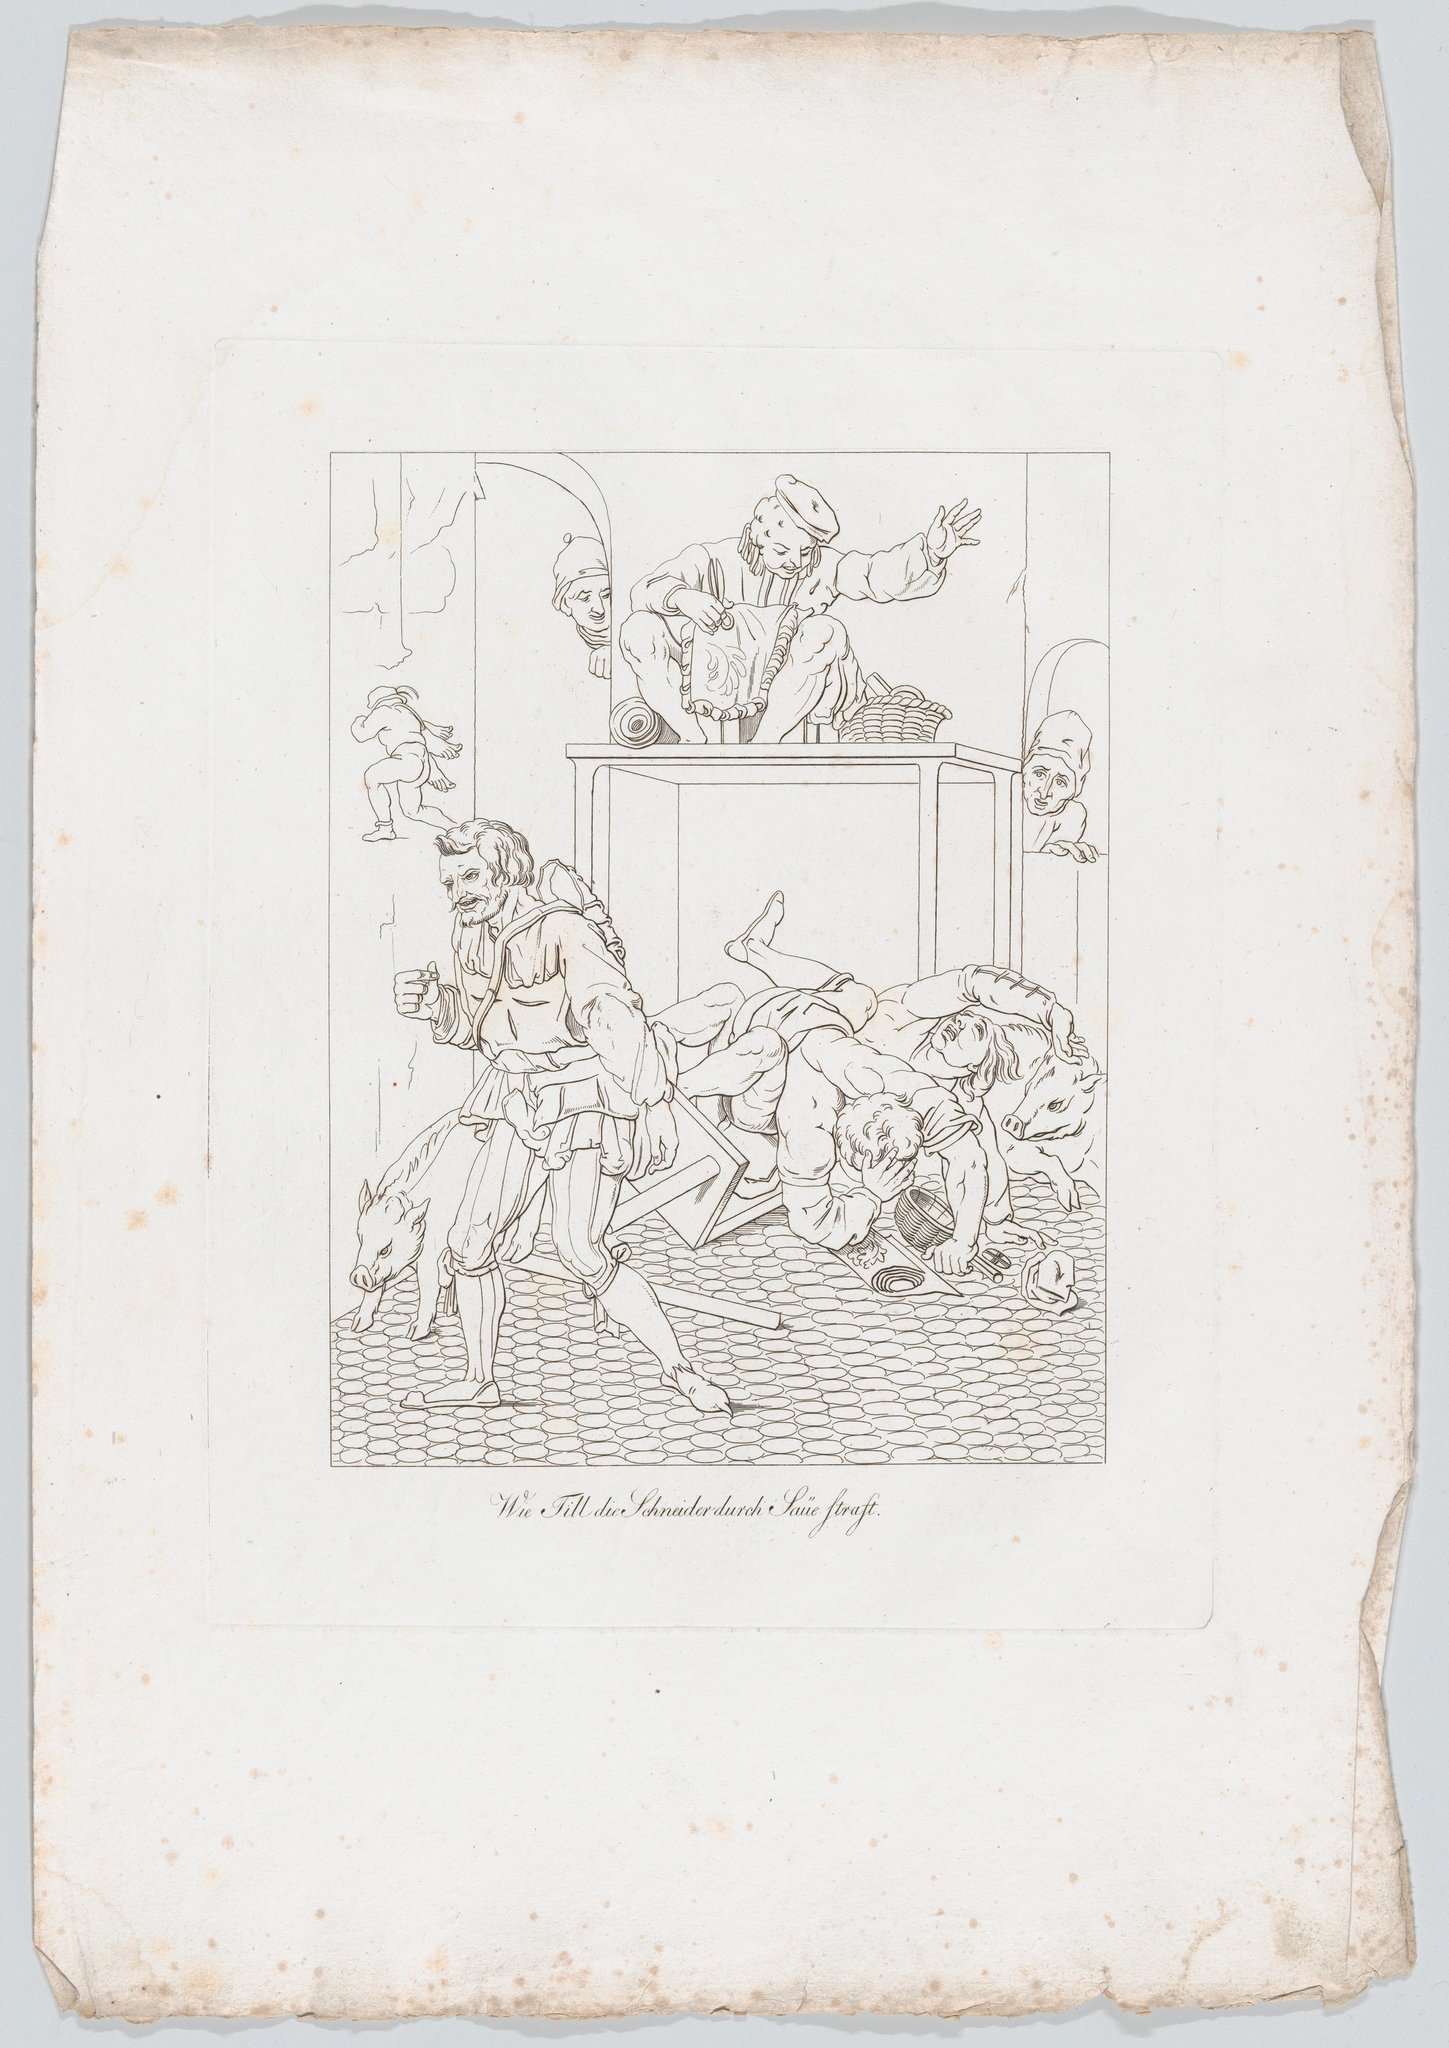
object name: print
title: Wie Till die Schneider duch Saüe straft (How Till Eugenspiegel Punished the Tailors)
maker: johann heinrich lips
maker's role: engraver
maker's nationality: swiss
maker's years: 1758-1817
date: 1806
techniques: engraving, etching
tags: men,pigs,punishment